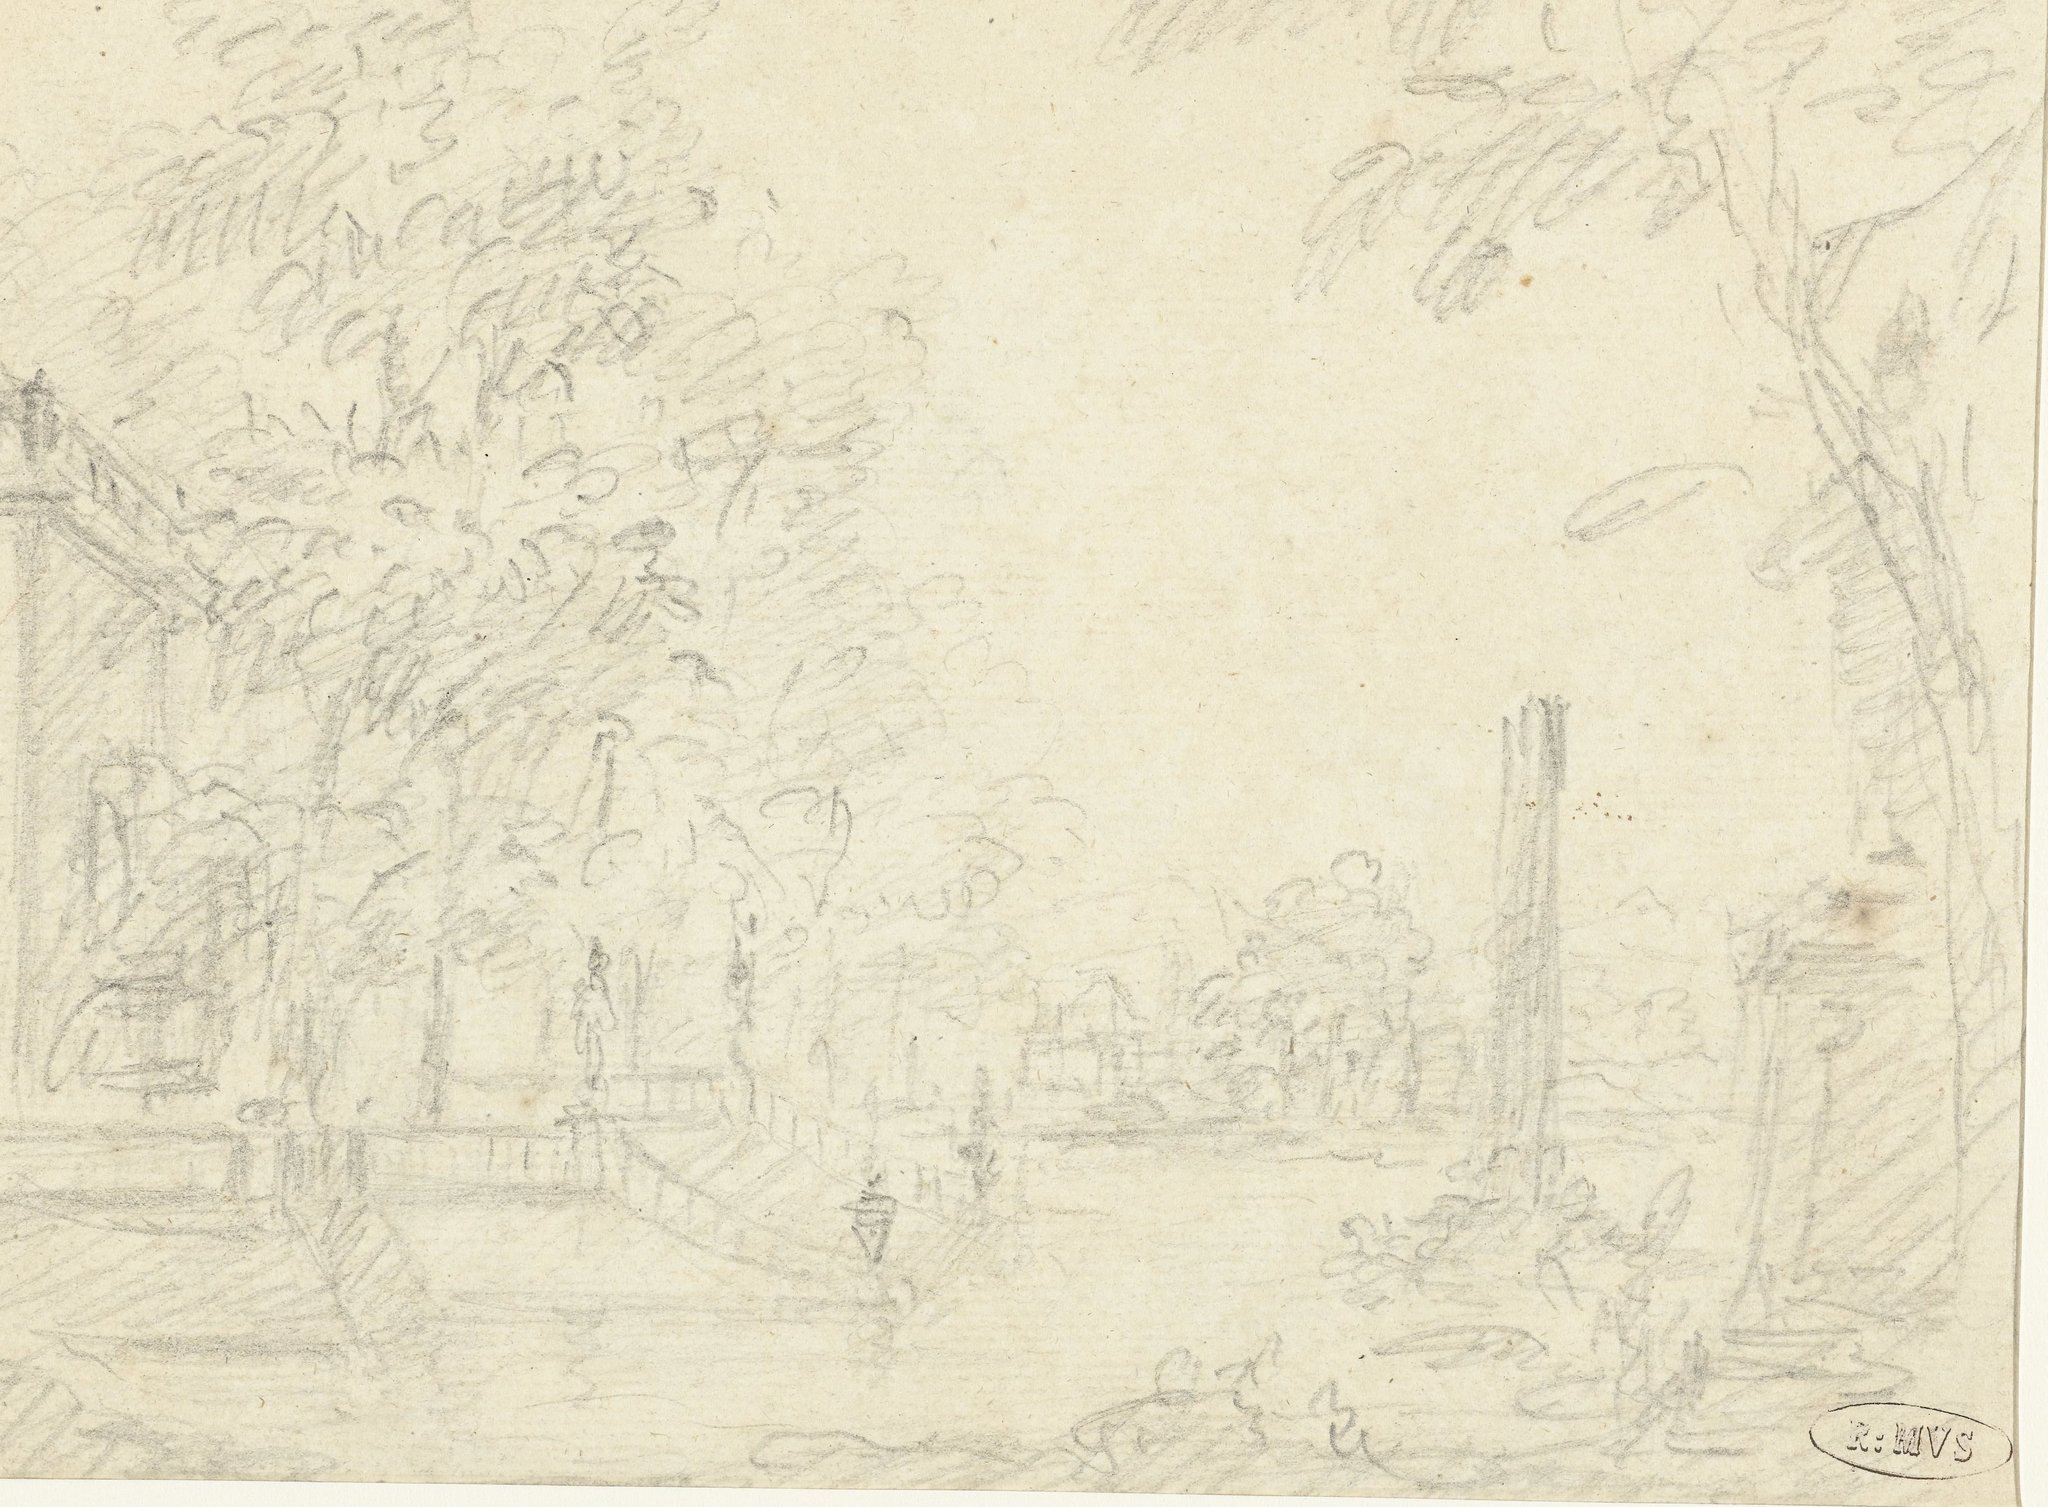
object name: drawing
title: Villa met tuin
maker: dionys van nijmegen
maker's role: draughtsman, painter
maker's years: 1705-1798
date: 1715-1798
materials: paper, pencil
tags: garden